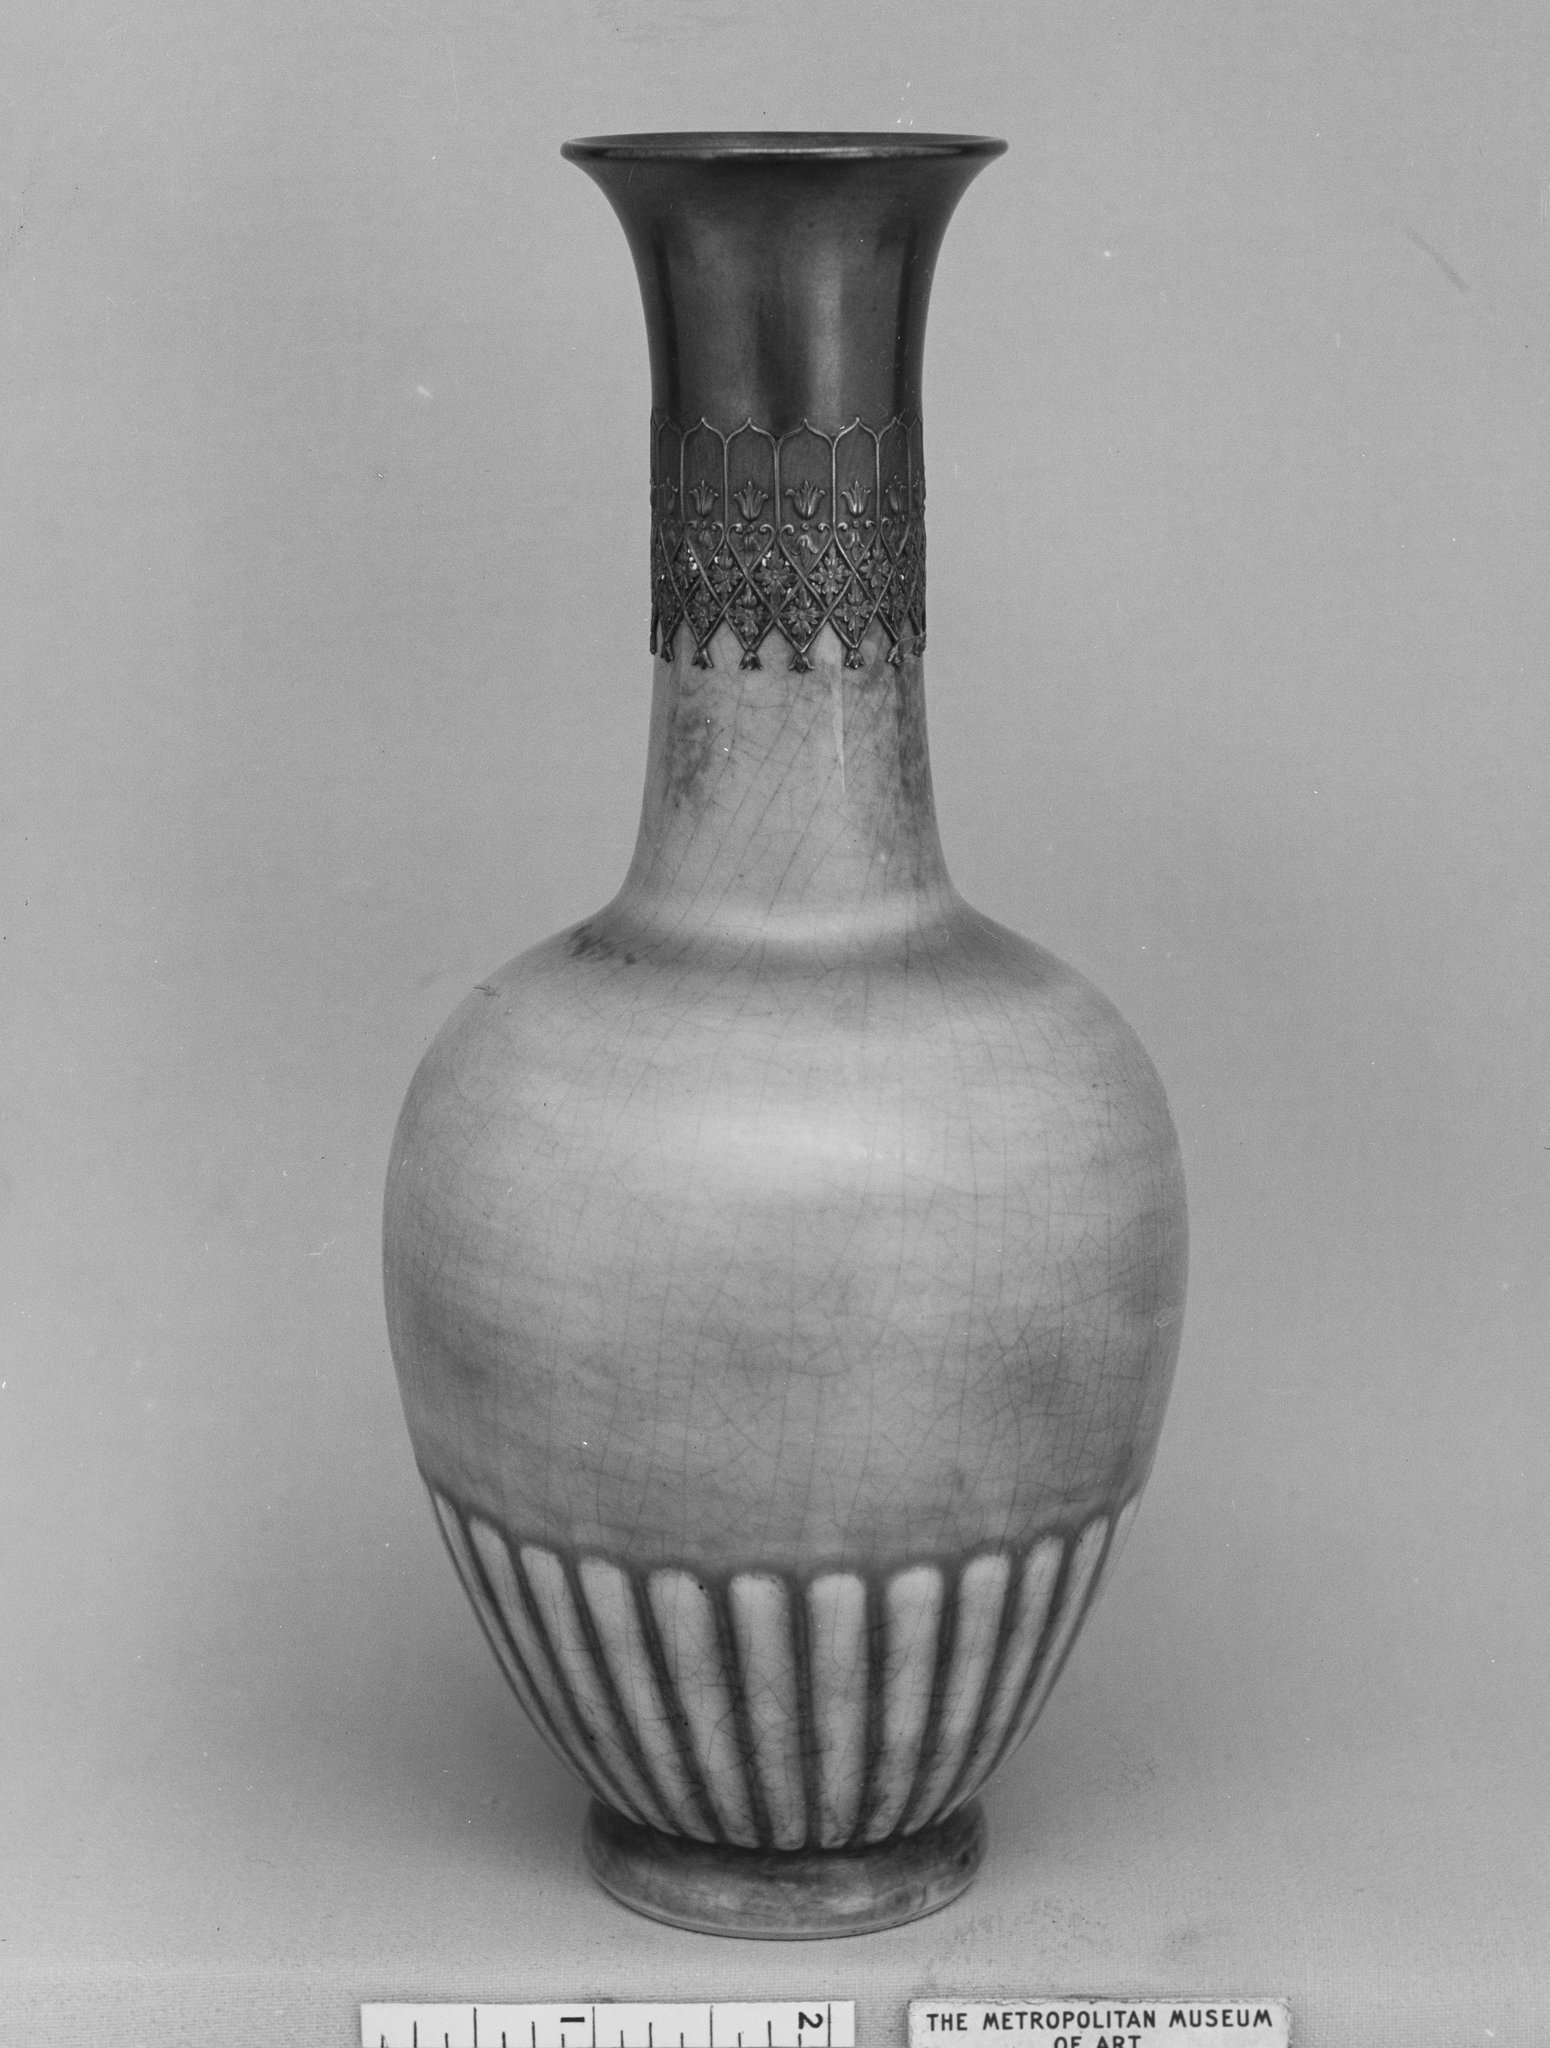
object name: vase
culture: chinese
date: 1662-1722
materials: porcelain